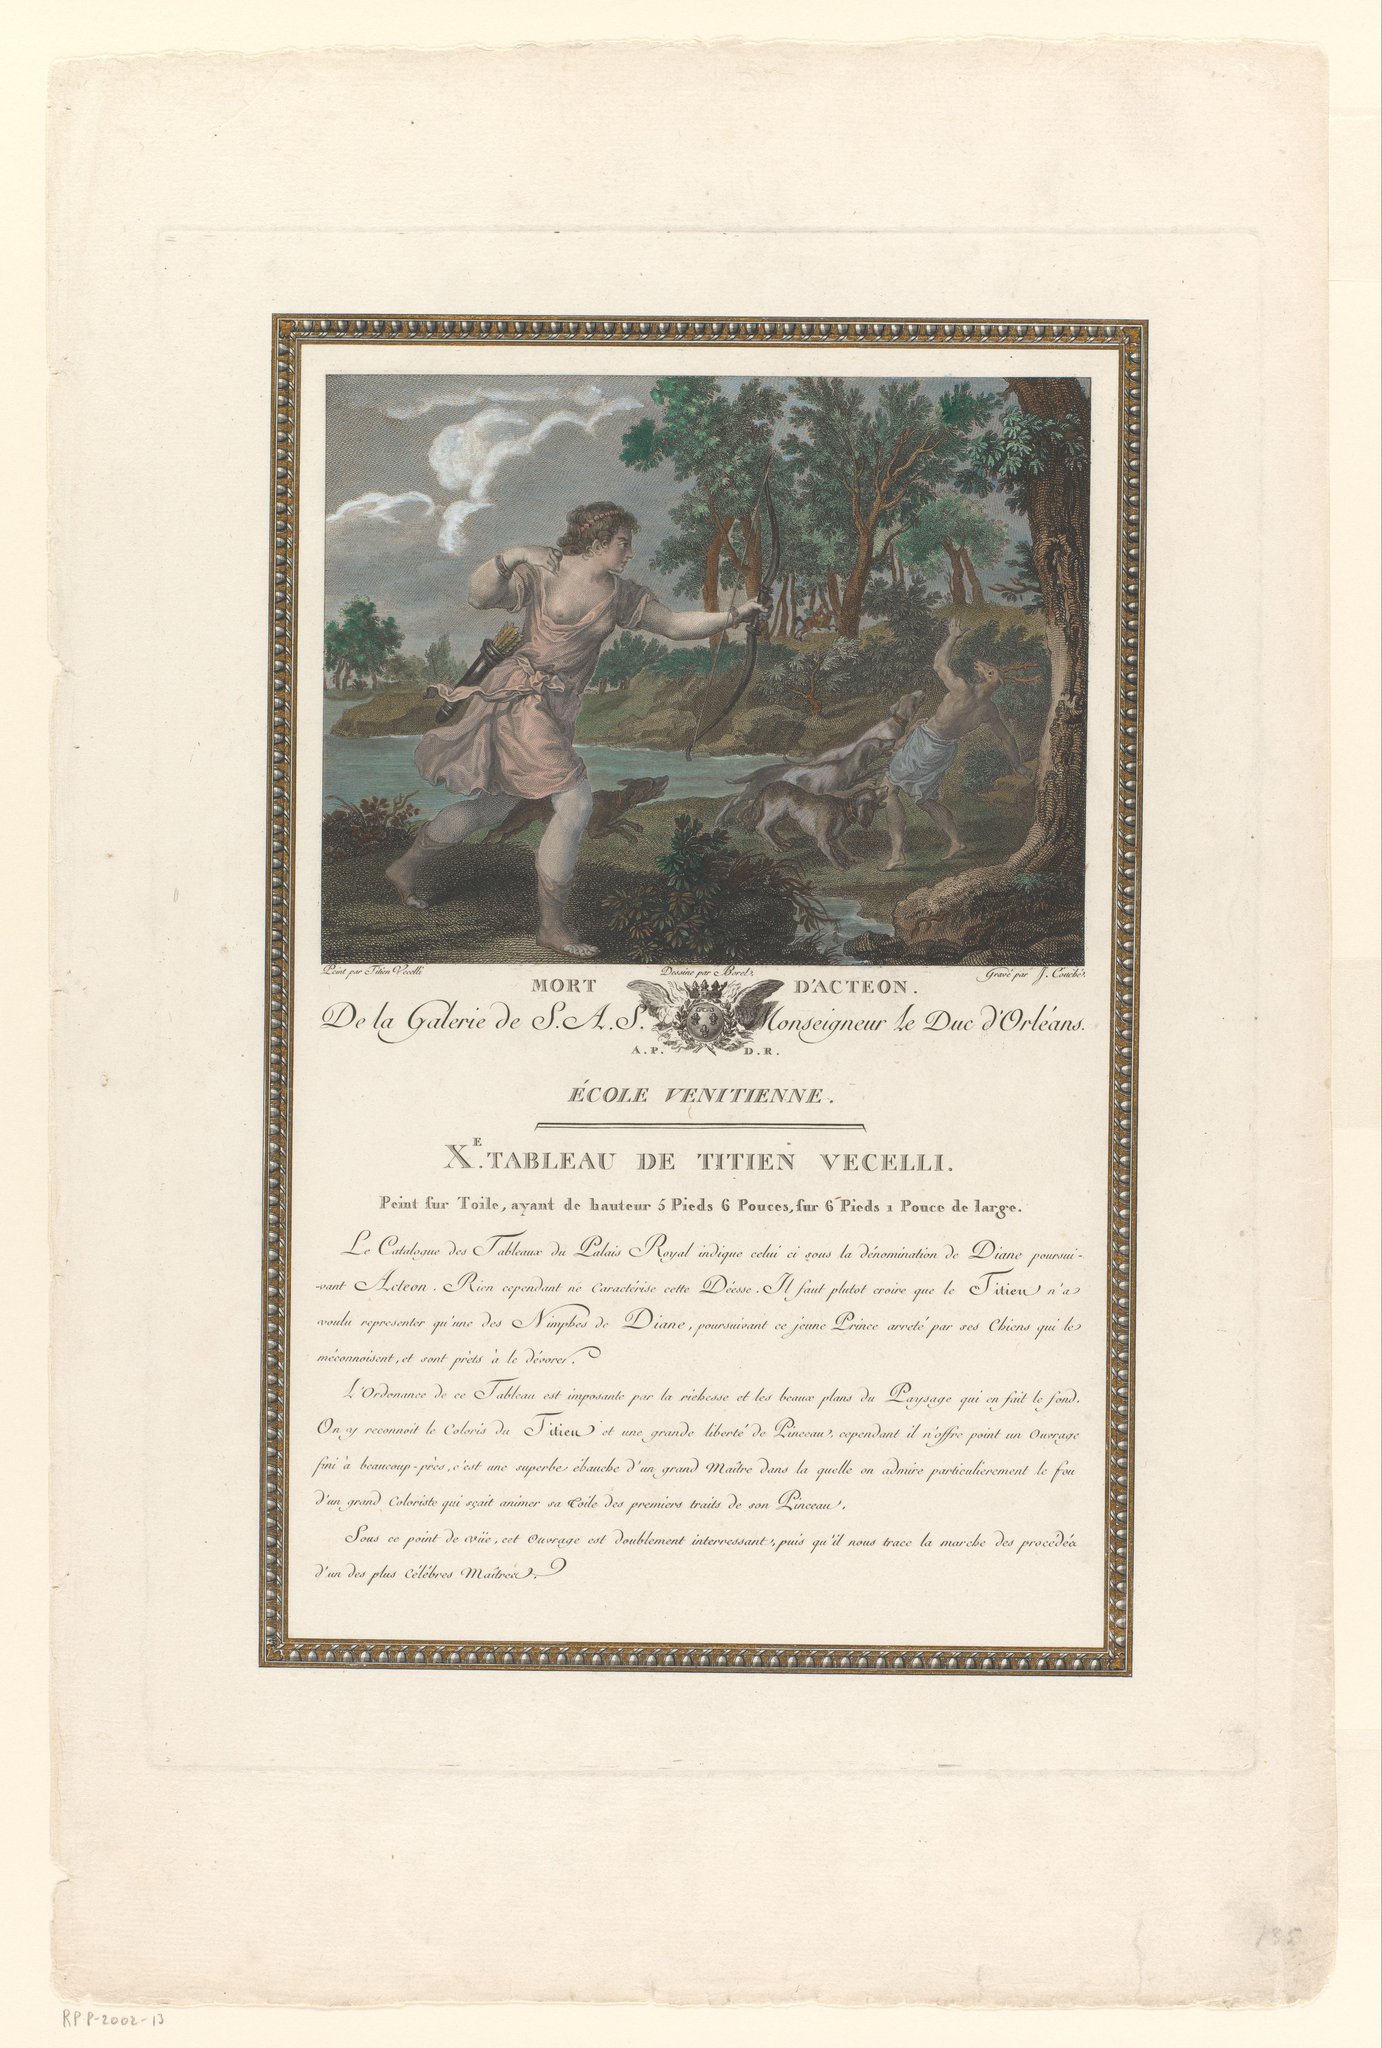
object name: print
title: Schilderijen uit de collectie van de Hertog van Orléans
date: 1786-1808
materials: paper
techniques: engraving, etching, hand coloring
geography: paris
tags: actaeon as a stag is devoured by his own dogs, armorial bearing, heraldry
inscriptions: inscription: ‘X. Tableau de Tien Vecelli...Le Catalogue des Tableaux...des plus célèbres Maitres.’, signature: ‘Dessiné par Borel’, title: ‘MORT D' ACTEON’, collector's mark: Lugt 2228, signature: ‘Peint par Titien Vecelli’, signature: ‘Gravé par J. Chouché’, collector's mark: Lugt 2760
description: Diana, op de voorgrond links te zien, schiet de pijl af waarmee ze Actaeon, in de gedaante van een hert, doodt. Haar honden vallen hem aan. Landschap met rivier en bomen. Onder de voorstelling de titel en een uitleg over het schilderij in het Frans. Voorstelling en tekst omkaderd door een sierlijst.